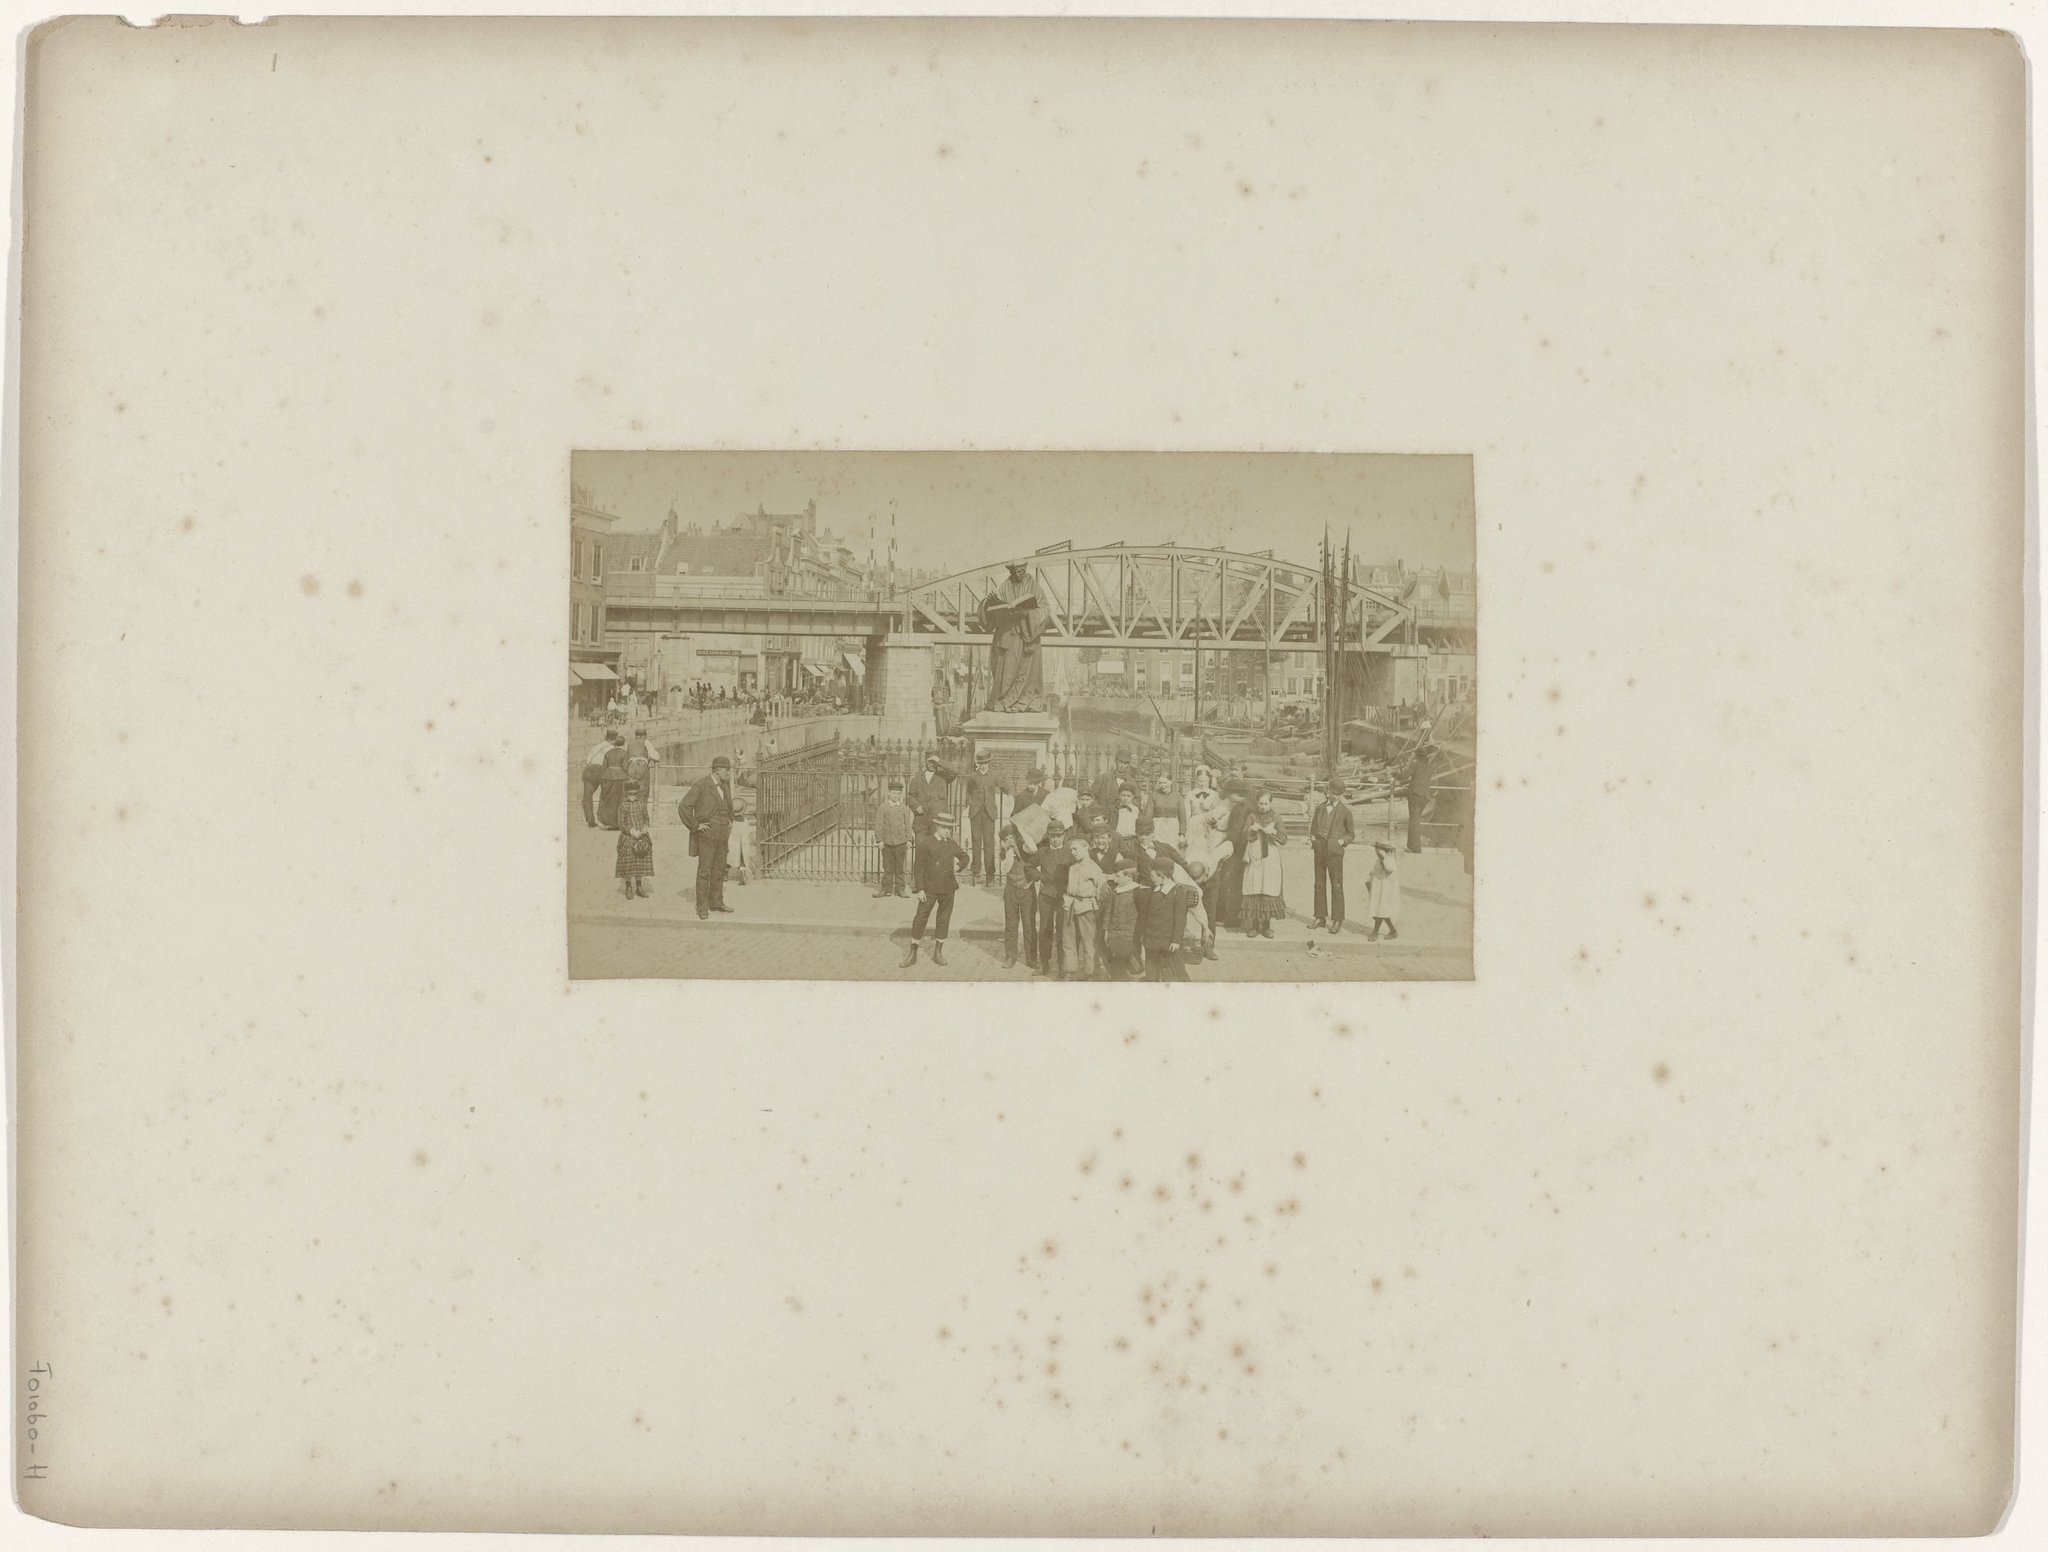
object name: photograph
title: Publiek bij het standbeeld van Erasmus op de Grote Markt in Rotterdam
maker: Anonymous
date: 1880-1900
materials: photographic support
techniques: albumen print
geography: grotemarkt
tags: rotterdam, desiderius erasmus, monument, statue, railway, train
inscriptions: inscription: ‘Groote Markt’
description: Onderdeel van Fotoalbum met stadsgezichten van Rotterdam.